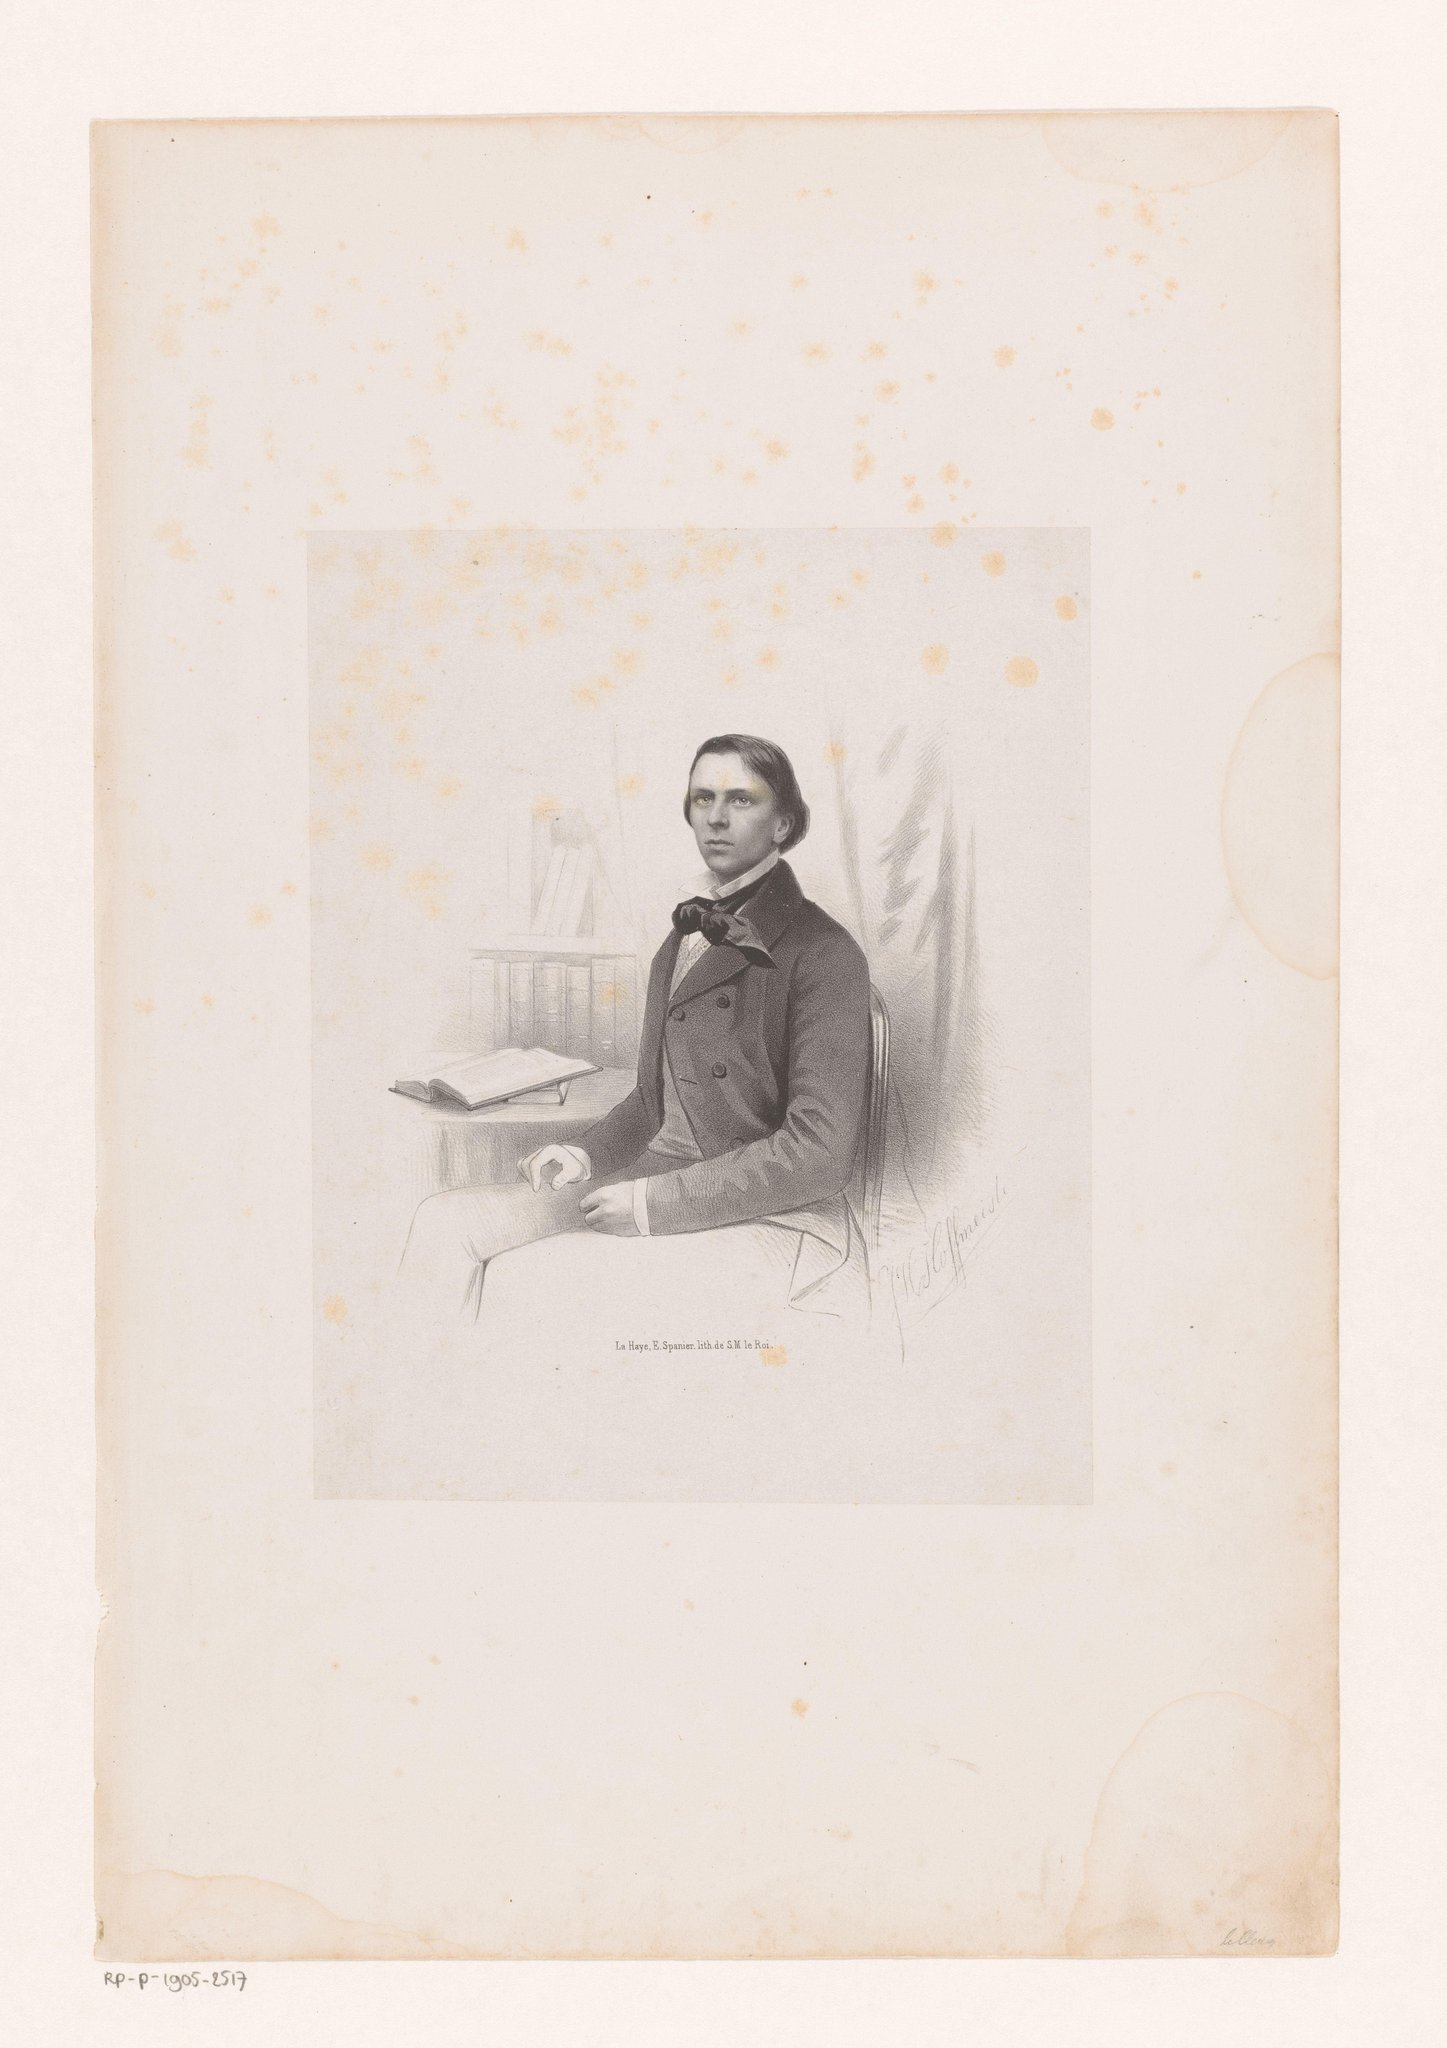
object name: print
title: Portret van heer Le Clercq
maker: johan hendrik hoffmeister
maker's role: print maker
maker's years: 1823-1904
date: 1851-1883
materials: paper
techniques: lithograph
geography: netherlands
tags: historical persons (+ three-quarter length portrait), looking upwards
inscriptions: collector's mark: Lugt 2228